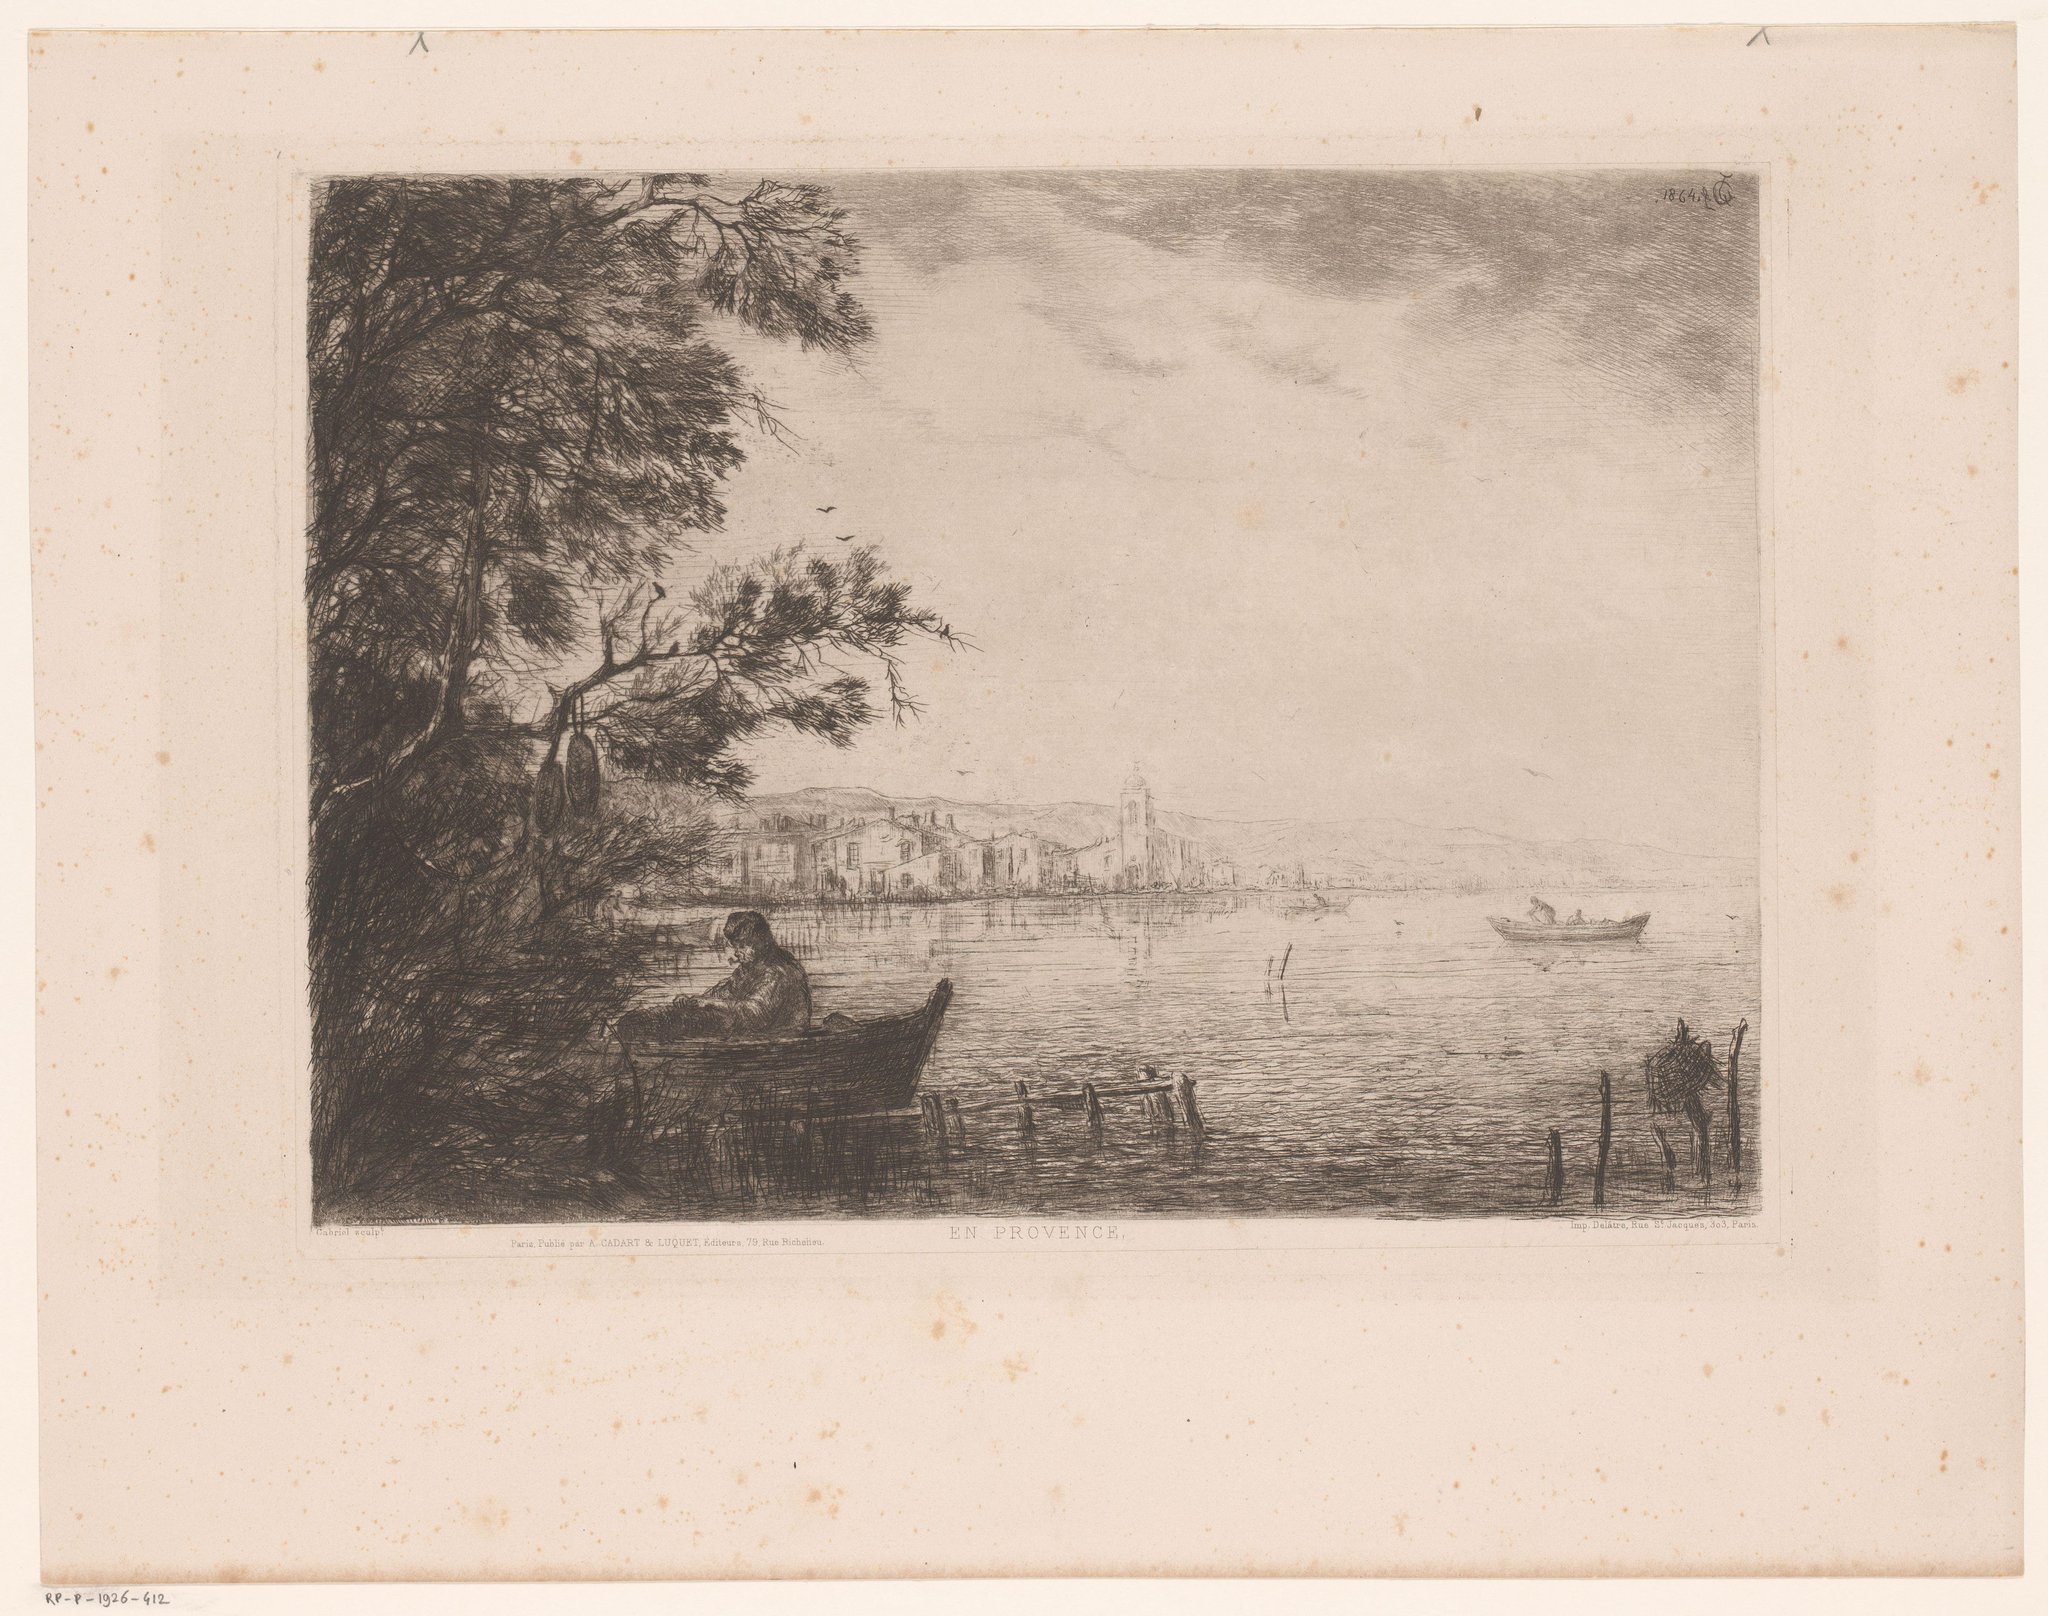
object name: print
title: Twee badende vrouwen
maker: justin gabriel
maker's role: print maker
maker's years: 1838-1923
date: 1909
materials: paper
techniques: drypoint, intaglio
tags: taking a bath - aa - in the open air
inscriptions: stamp: ‘Letter 'G' in een cirkel.’ Lugt 1129b, collector's mark: Lugt 2228